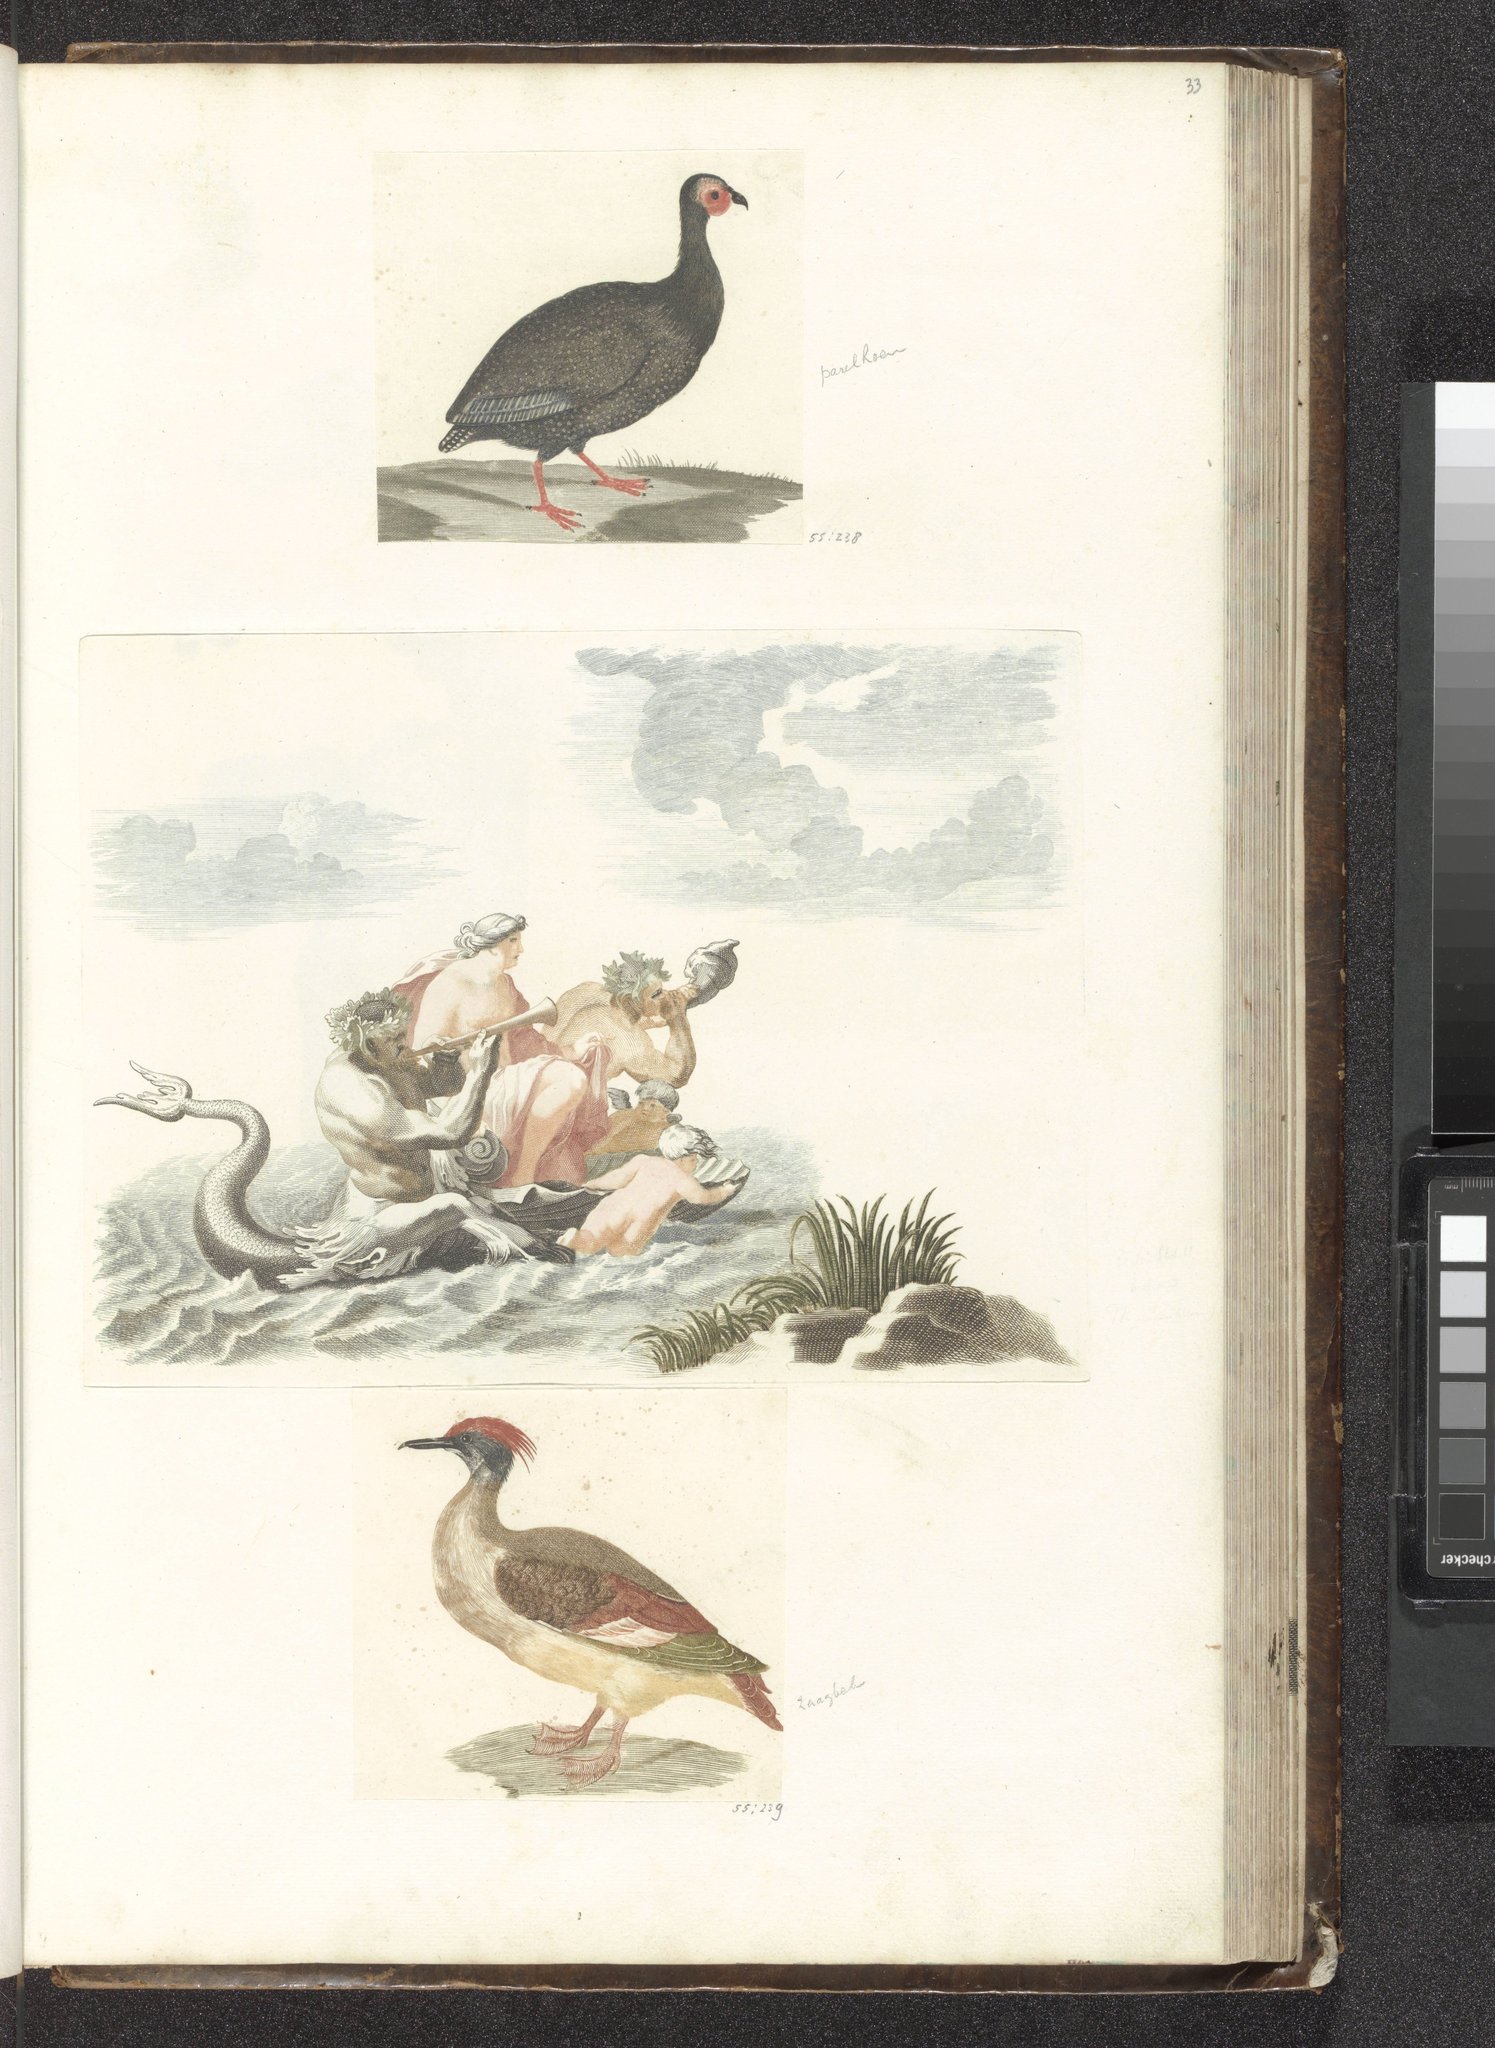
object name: album leaf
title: Parelhoen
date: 1688-1698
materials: paper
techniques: printing, engraving, lithography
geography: netherlands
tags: fowl (cock, hen, chicken, etc.)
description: Deze prent maakt deel uit van een album.